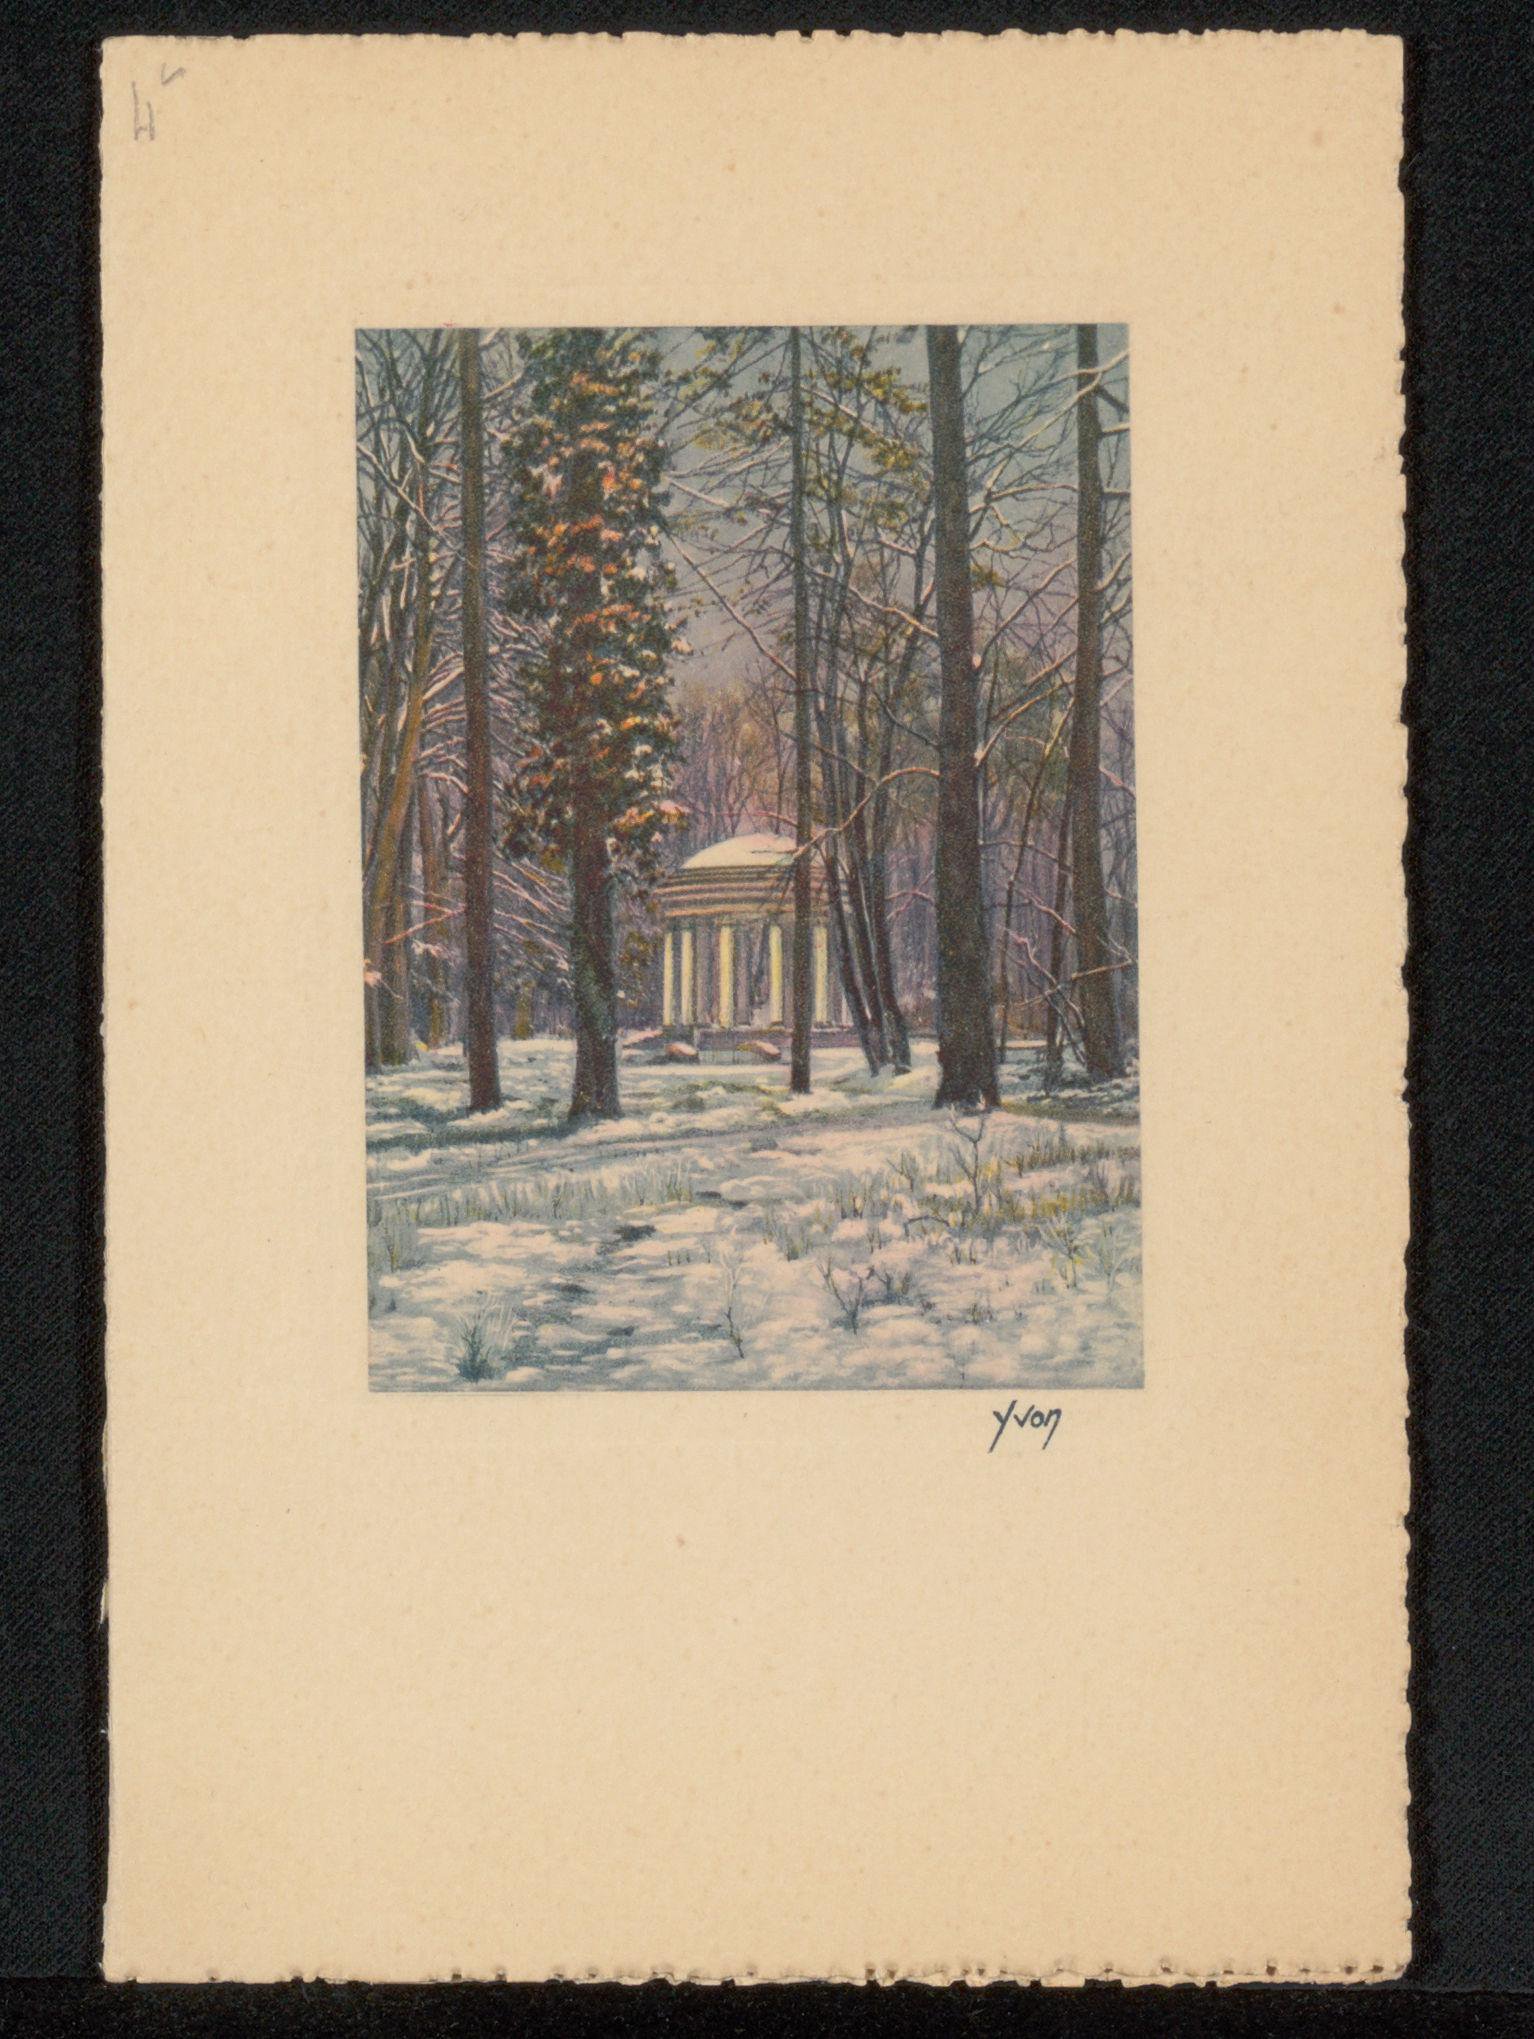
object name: letter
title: Brief aan Henriette Wilhelmina van Baak en Philip Zilcken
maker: marianne von der launitz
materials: ink, paper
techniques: pen, rotogravure, writing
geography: auteuil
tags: henriette wilhelmina van baak, the hague, painter, draughtsman, philip zilcken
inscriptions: collector's mark: ‘RPK’